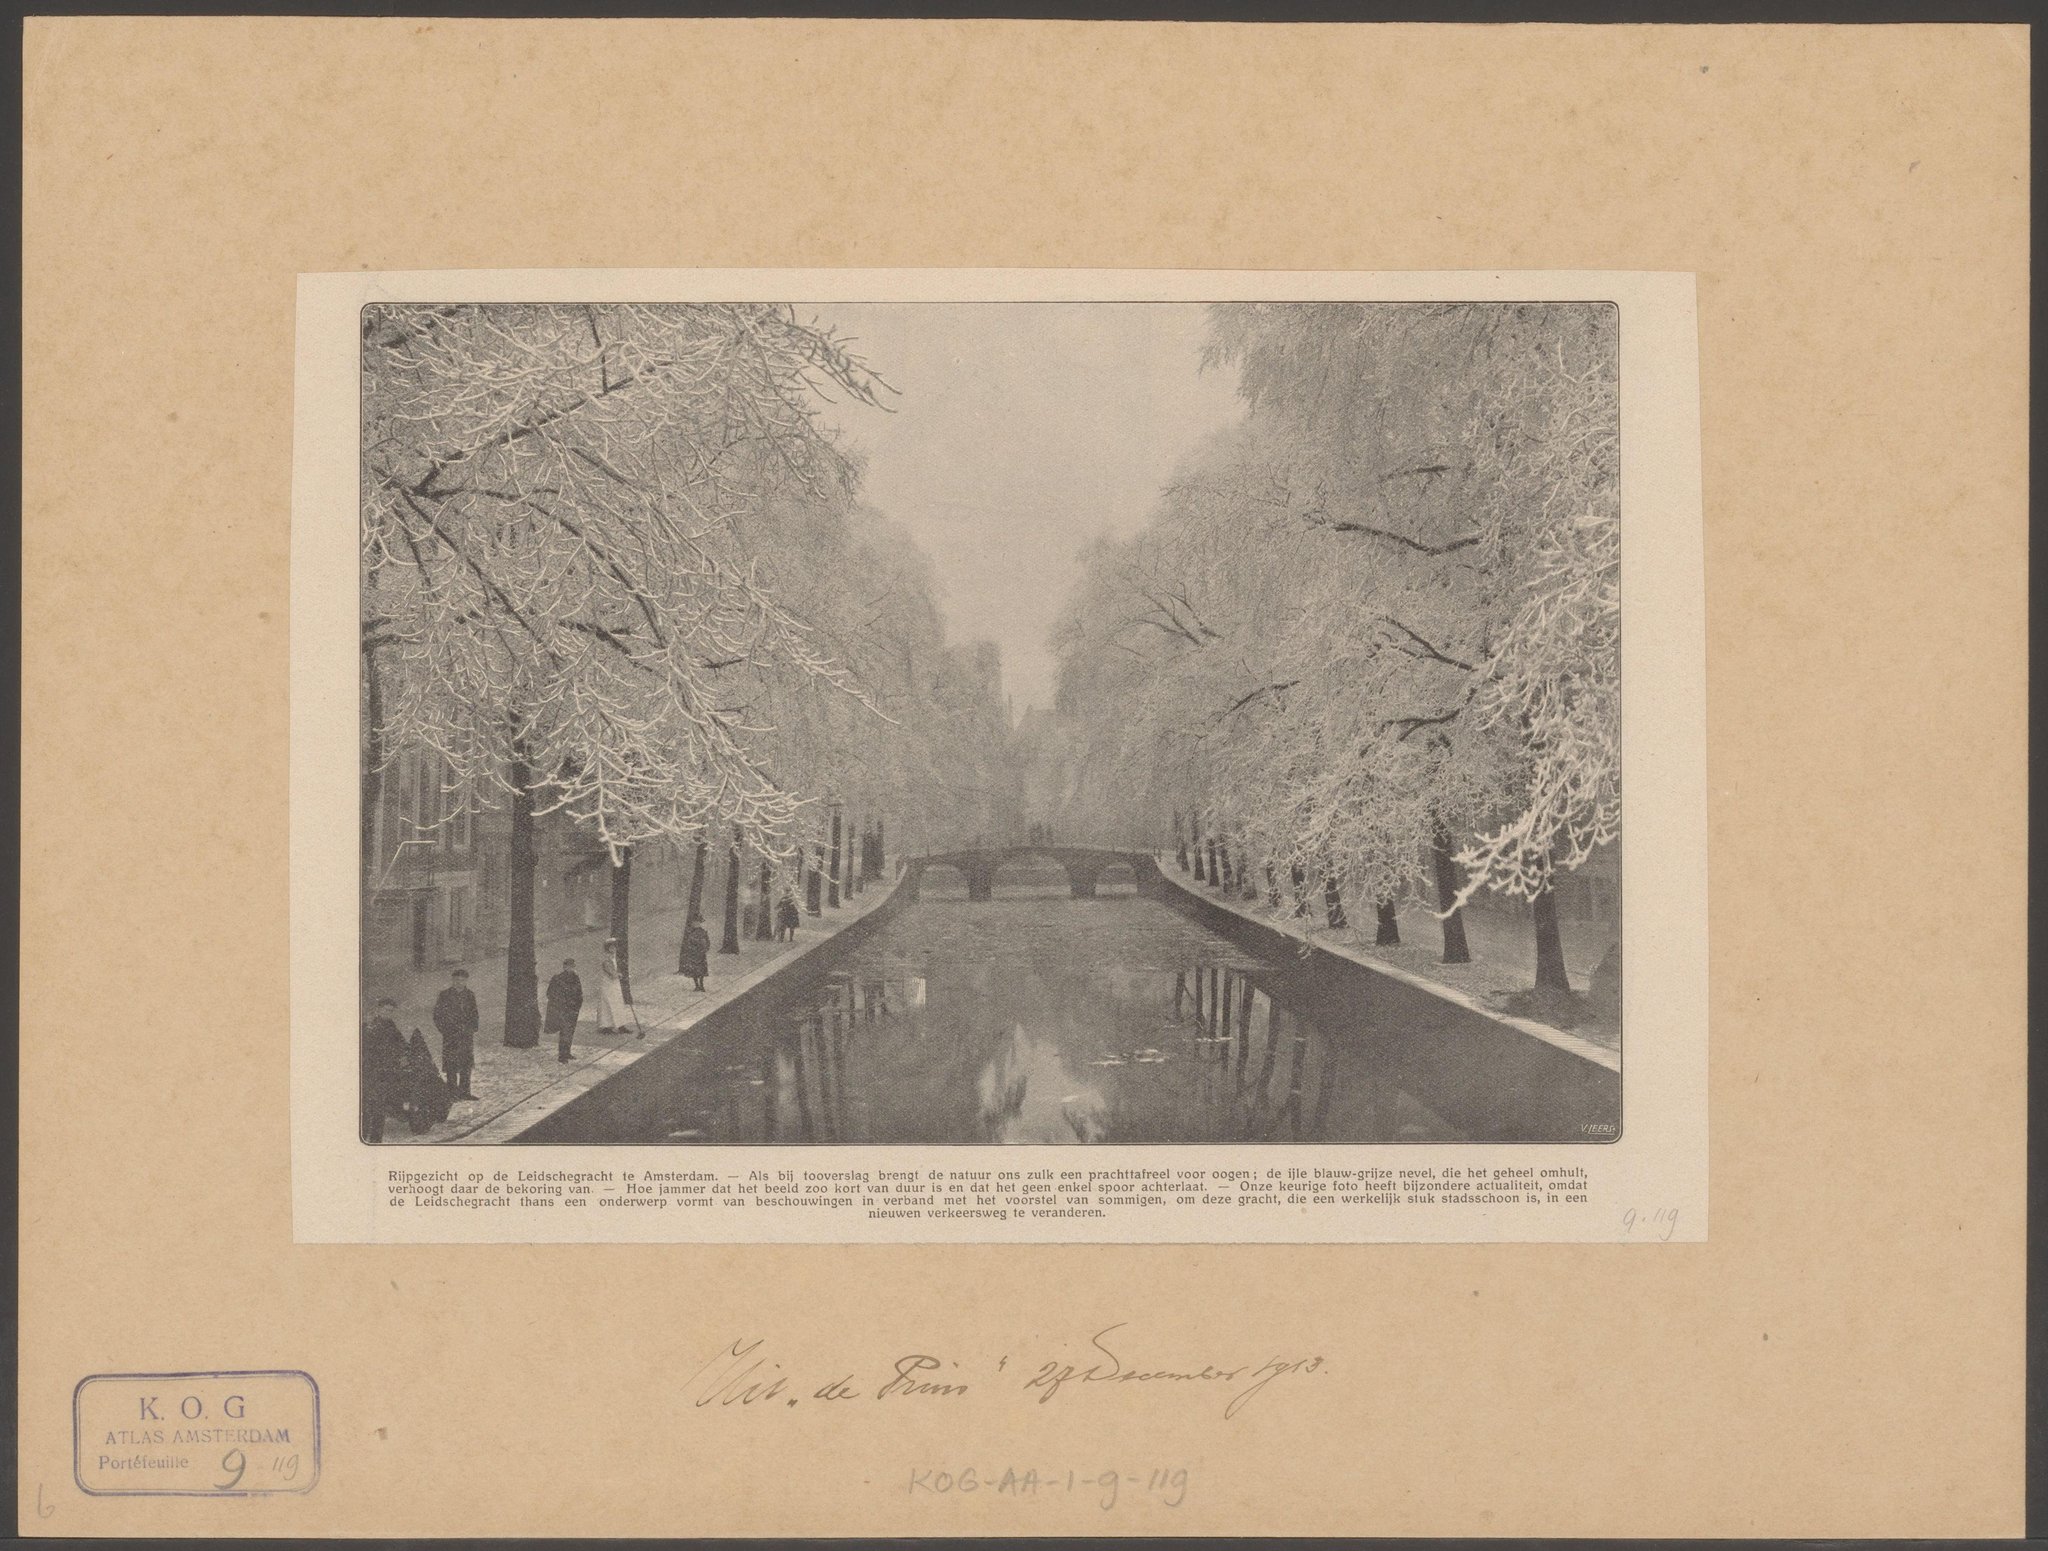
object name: photomechanical print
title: Wintergezicht op de Leidsegracht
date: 1913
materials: paper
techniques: letterpress printing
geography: amsterdam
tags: city-view in general; 'veduta', canal, winter landscape; landscape symbolizing winter (the four seasons of the year), bridge in city across river, canal, etc.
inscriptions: collector's mark: ‘9.119’ Lugt 1641b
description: Onderwerpsrubriek binnen de Atlas Amsterdam: 2e Laurierdwarsstraat (Vuile Weespad), Leidschegracht, Leidschekade, Leidscheplein, Leidschestraat, v. Lennepkade, Lijnbaansgracht, Lauriergracht, Leliedwarsstraat, Leliegracht, Lindengracht, Lombardsteeg, Looiersgracht, Looiersstraat (Nieuwe), Leidekkerssteeg.